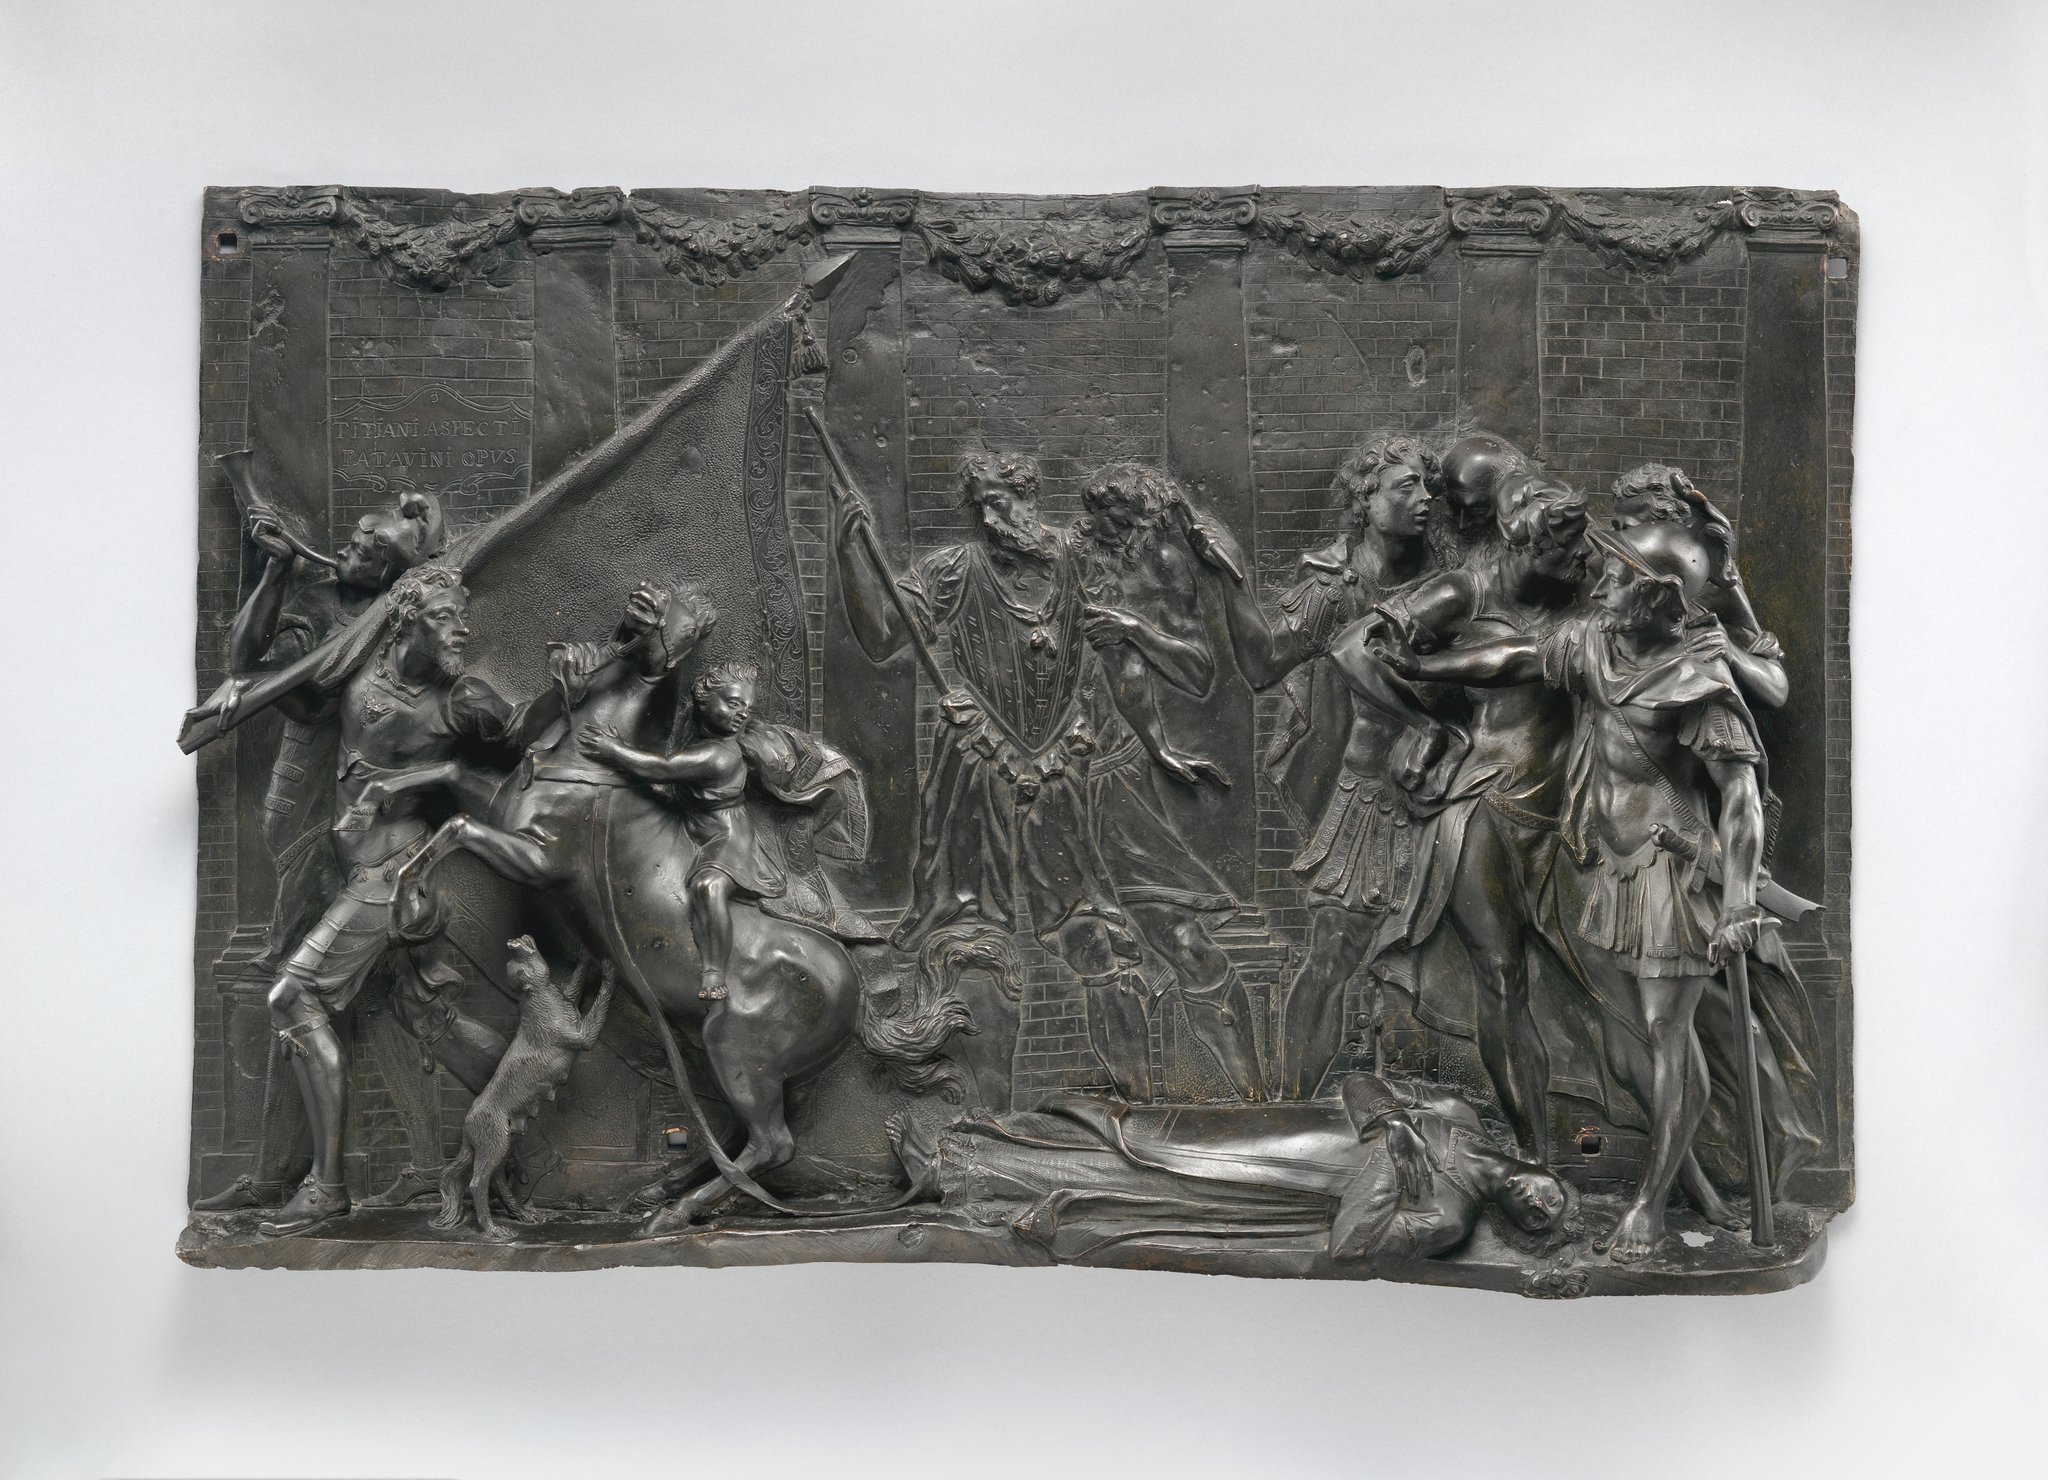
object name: relief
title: Saint Daniel of Padua dragged by a horse before the Roman governor of Padua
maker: francesco bertos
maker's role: artist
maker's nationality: italian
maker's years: 1678-1741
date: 1740-1750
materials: bronze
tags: suffering,men,horses,saints